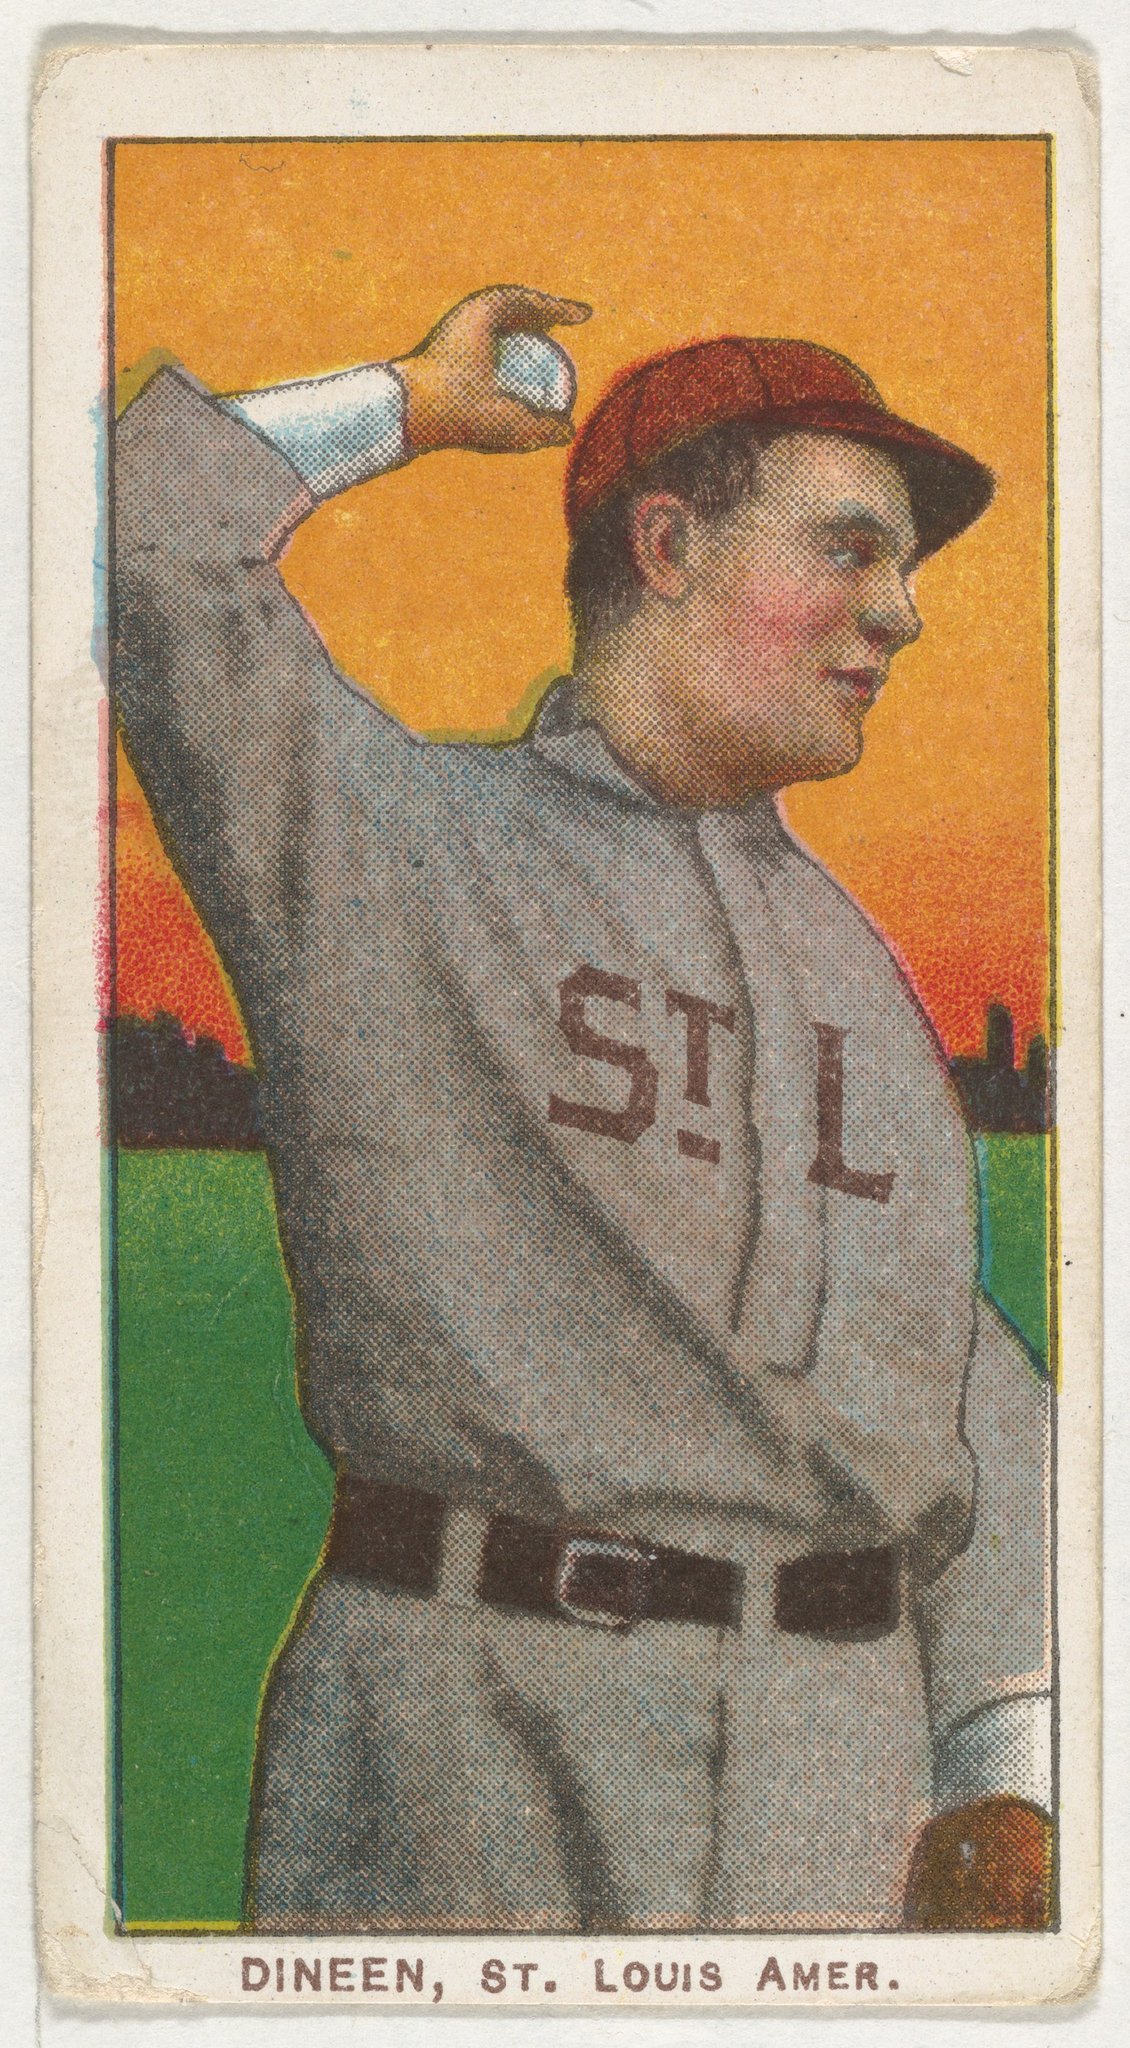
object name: baseball card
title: Dineen, St. Louis, American League, from the White Border series (T206) for the American Tobacco Company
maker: american tobacco company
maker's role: publisher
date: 1909-1911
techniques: lithography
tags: men,baseball,athletes